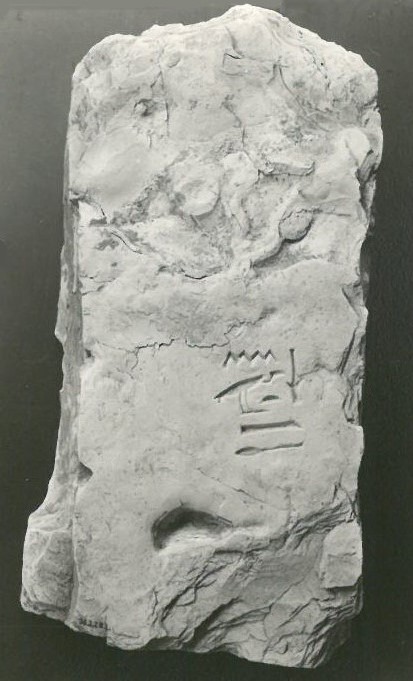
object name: name stone, tally, senenmut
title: Name Stone of Senenmut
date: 1479-1458 BCE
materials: limestone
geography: egypt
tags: hieroglyphs